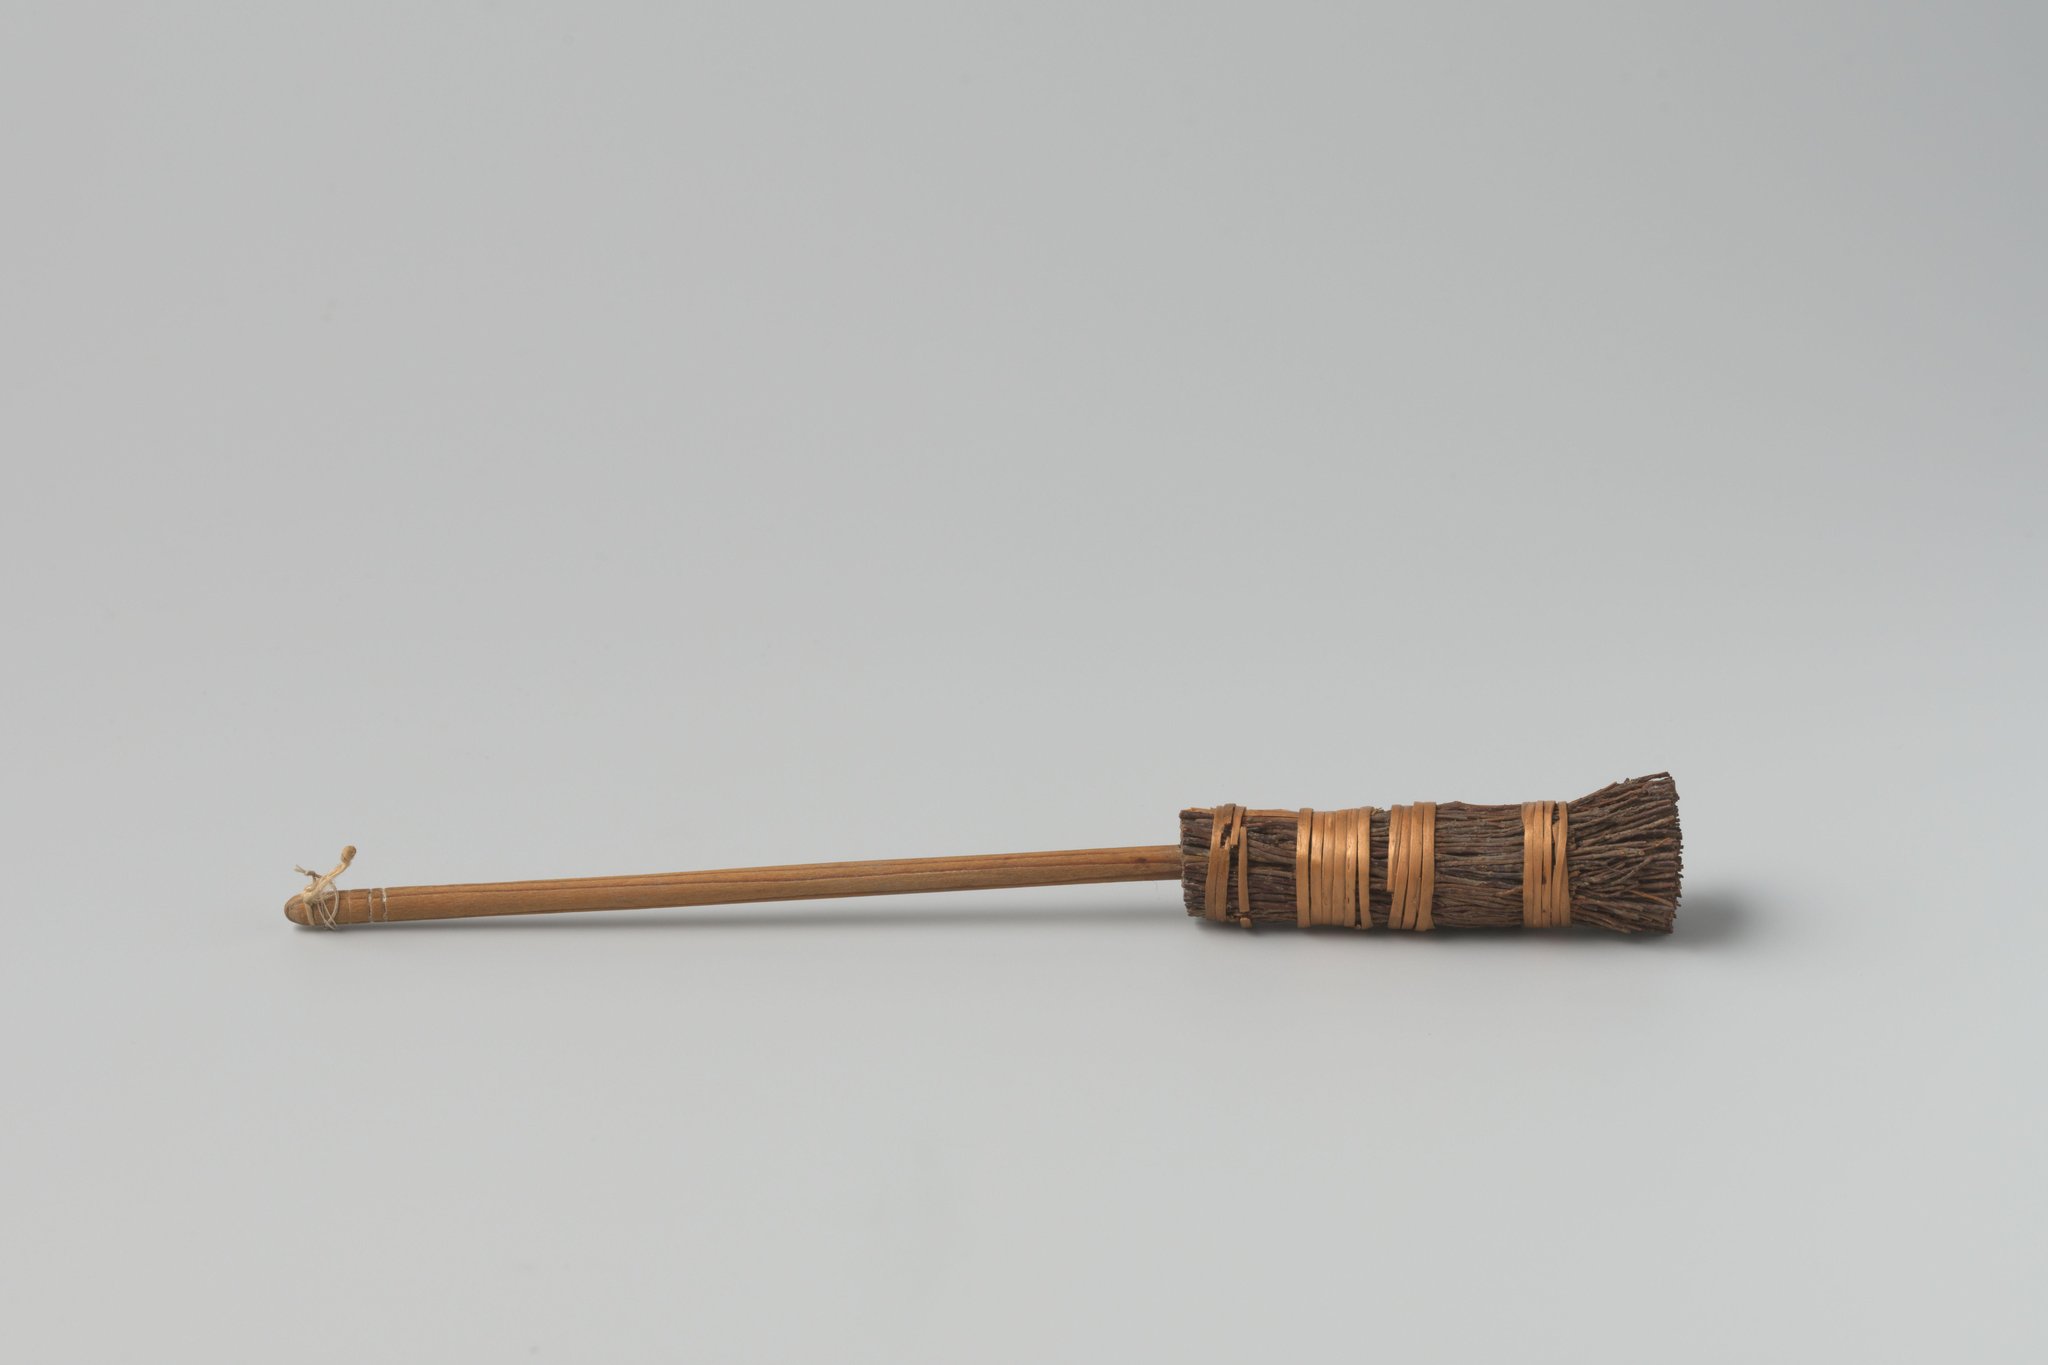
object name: broom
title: Bezem, bestaande uit een takkebos, samengebonden door wilgenteen, waarin gestoken een gladde steel van grenenhout met bovenaan vijf profielringen (voor touwtjes)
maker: Anonymous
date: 1690-1710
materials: plant material, wood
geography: amsterdam